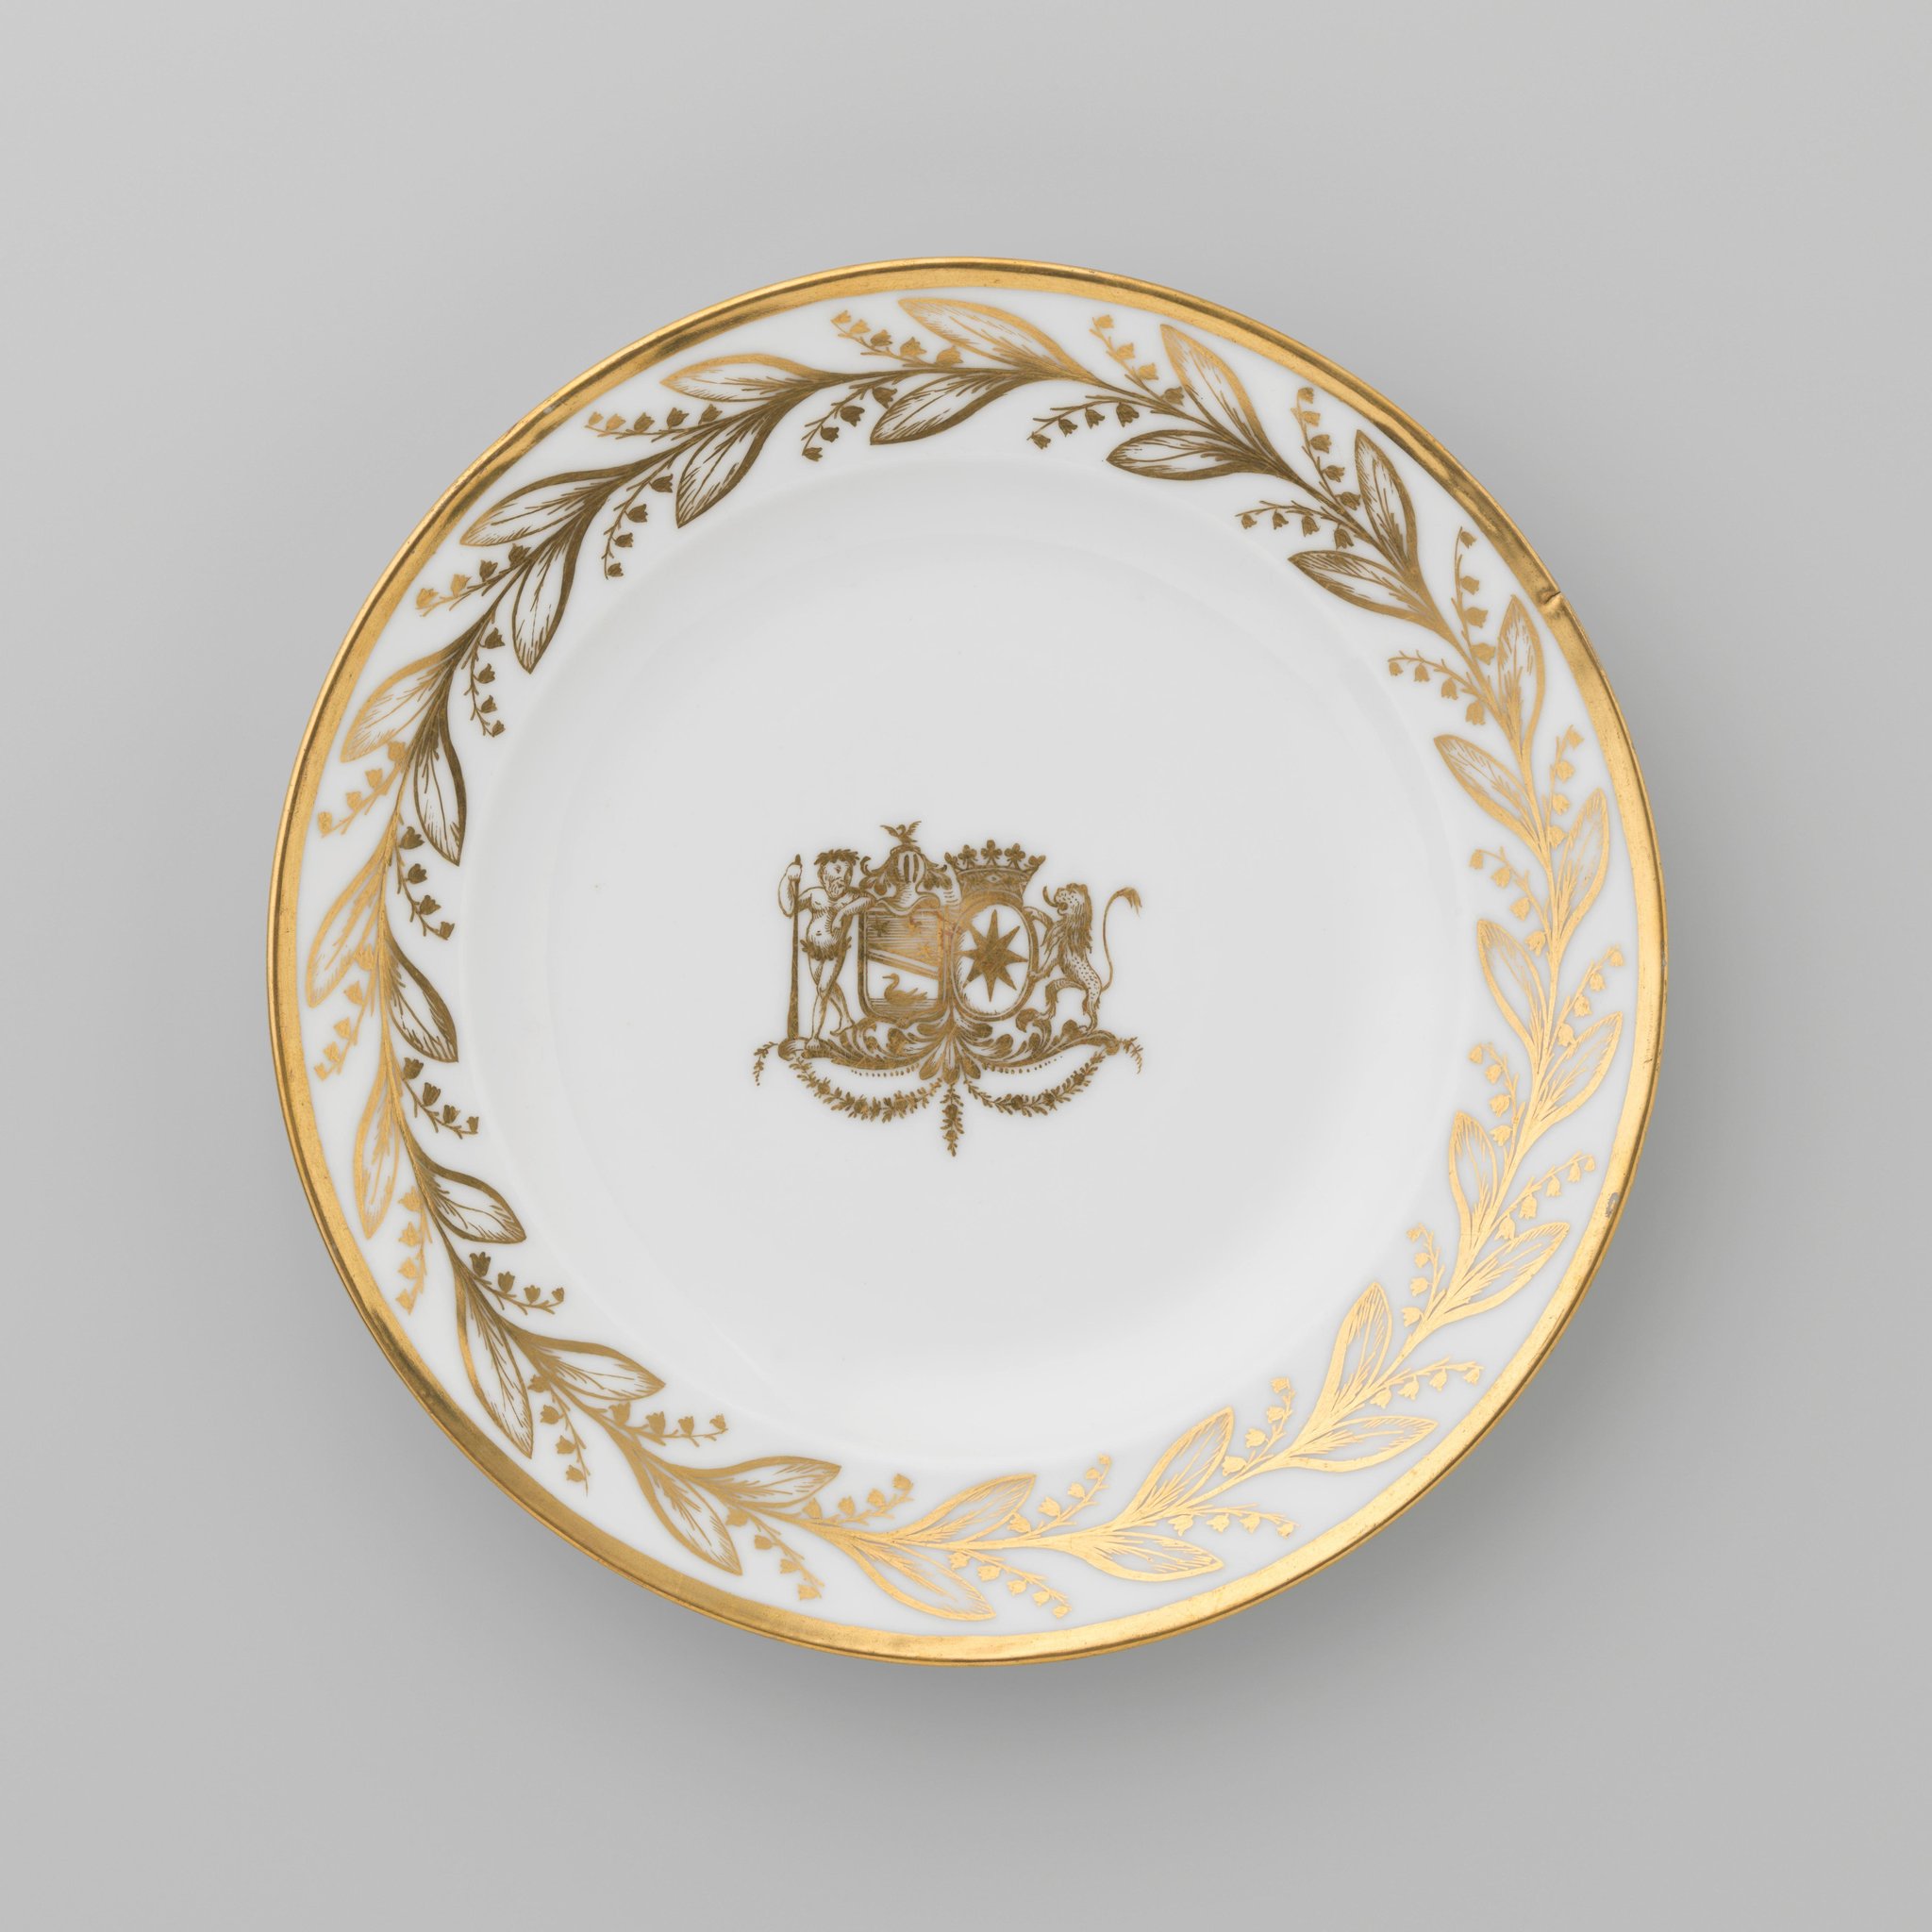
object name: plate dish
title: Plate with the coat of arms of Hendrik Peter Godfried Quack and Isabella Gertraud von Carnap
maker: Anonymous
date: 1790-1800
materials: glaze, gold, paint, porcelain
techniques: firing, forming, gilding, turning, vitrification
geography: netherlands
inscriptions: mark: ‘C’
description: Bord van porselein, beschilderd op het glazuur met goud. Op het plat het alliantiewapen van Hendrik Peter Godfried Quack en Isabella Gertraud von Carnap. De rand met een bloemrank en een gouden band. Drie proenen op de onderzijde. Gemerkt op de onderzijde met C.